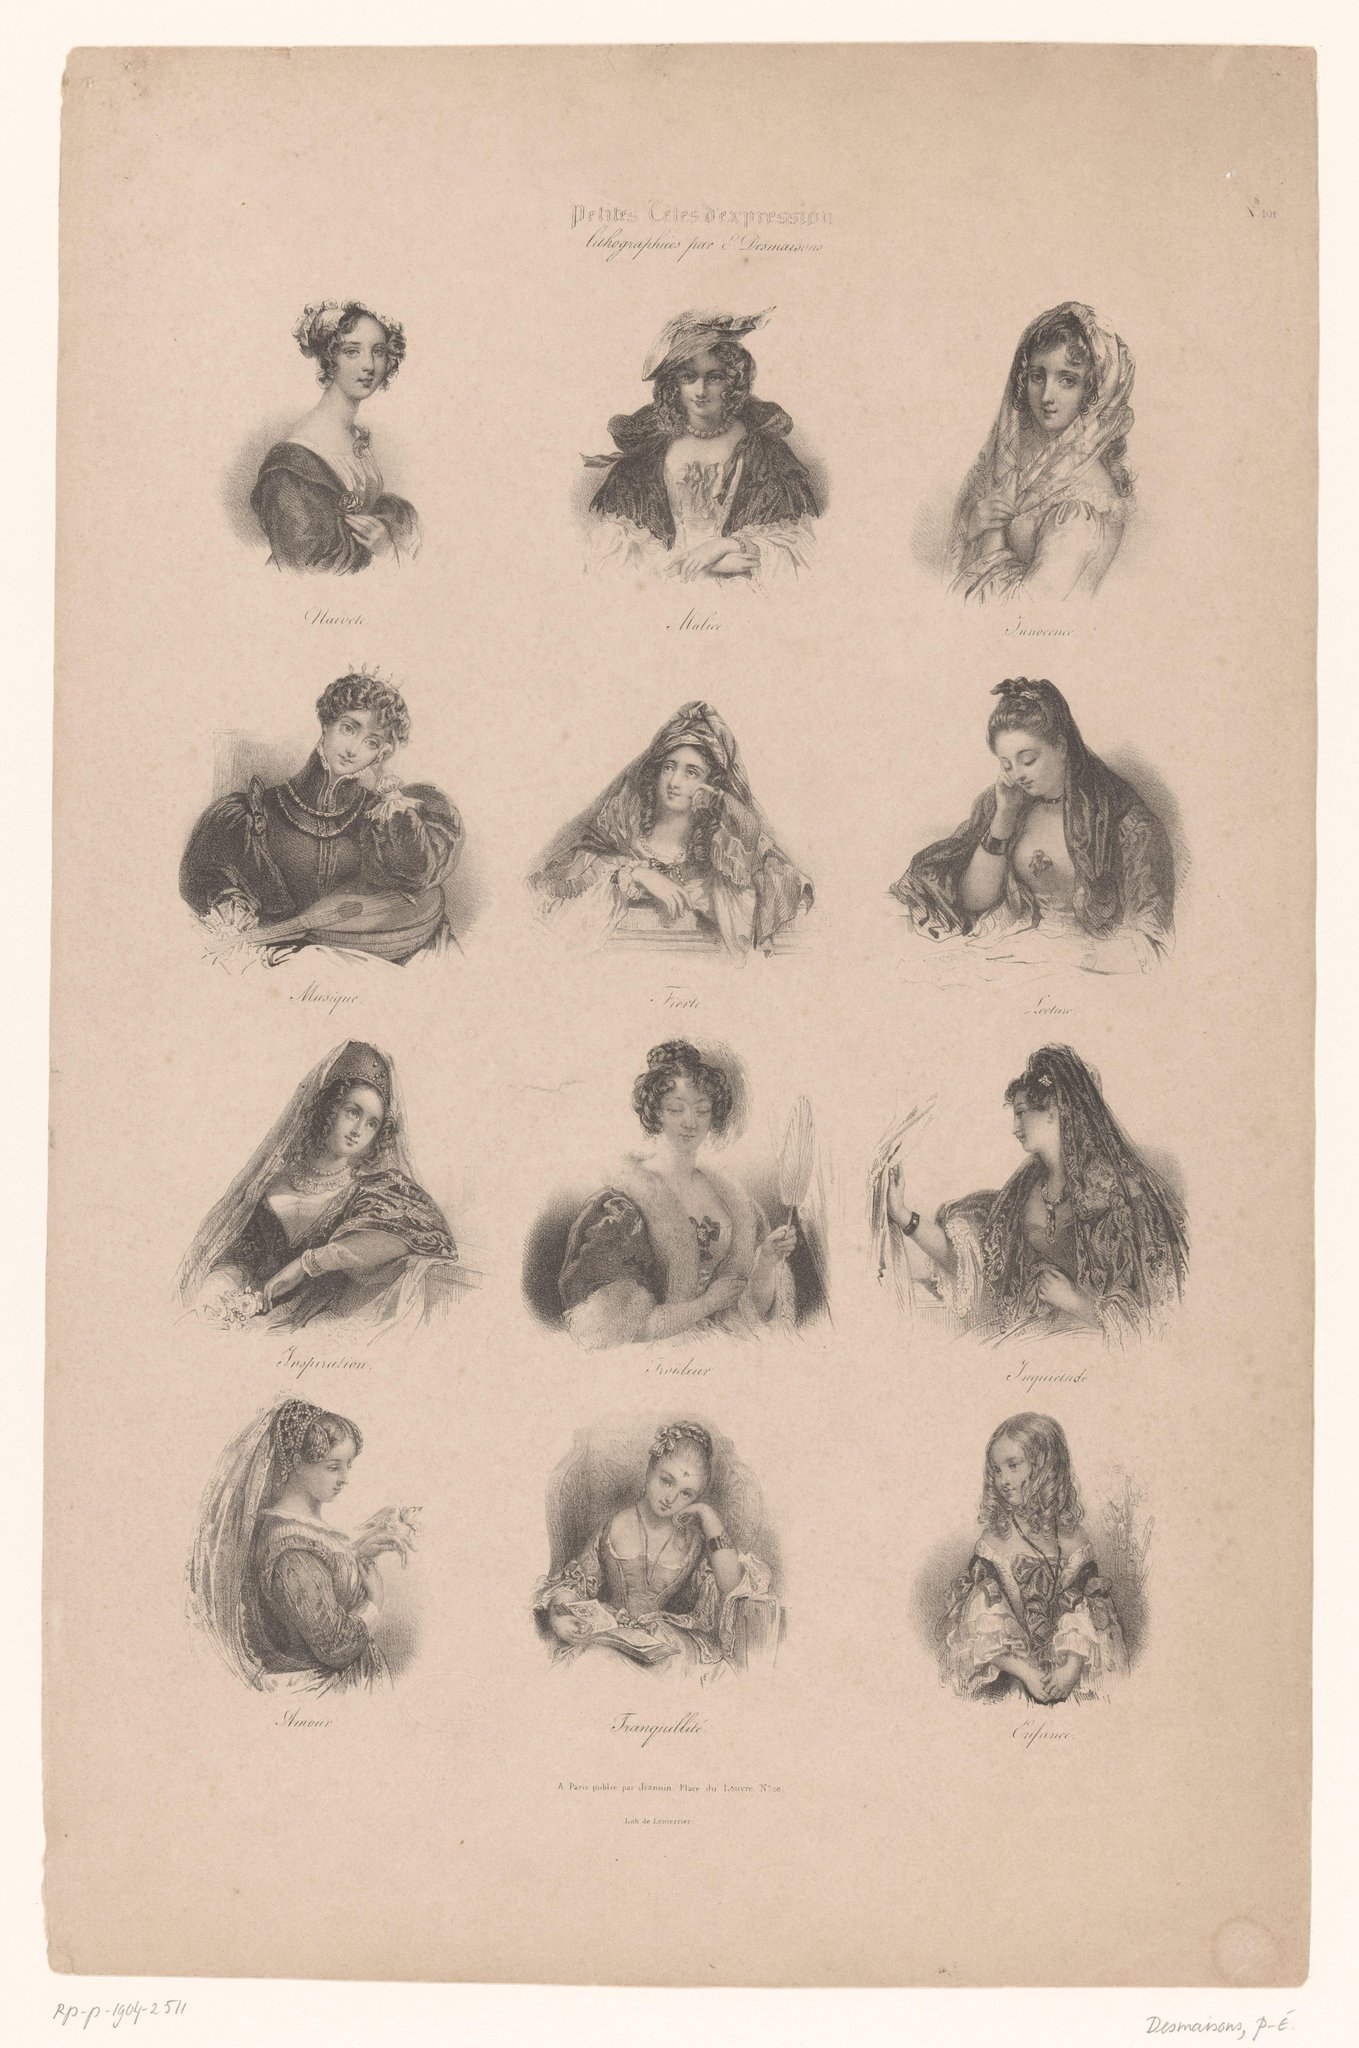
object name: print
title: Petites têtes d'expression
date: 1835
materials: paper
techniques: lithograph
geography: paris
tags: adolescent, young woman, maiden, morphology of human expression, chest, bust - aa - female human figure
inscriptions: collector's mark: Lugt 2228a, check stamp: Lugt 1397c